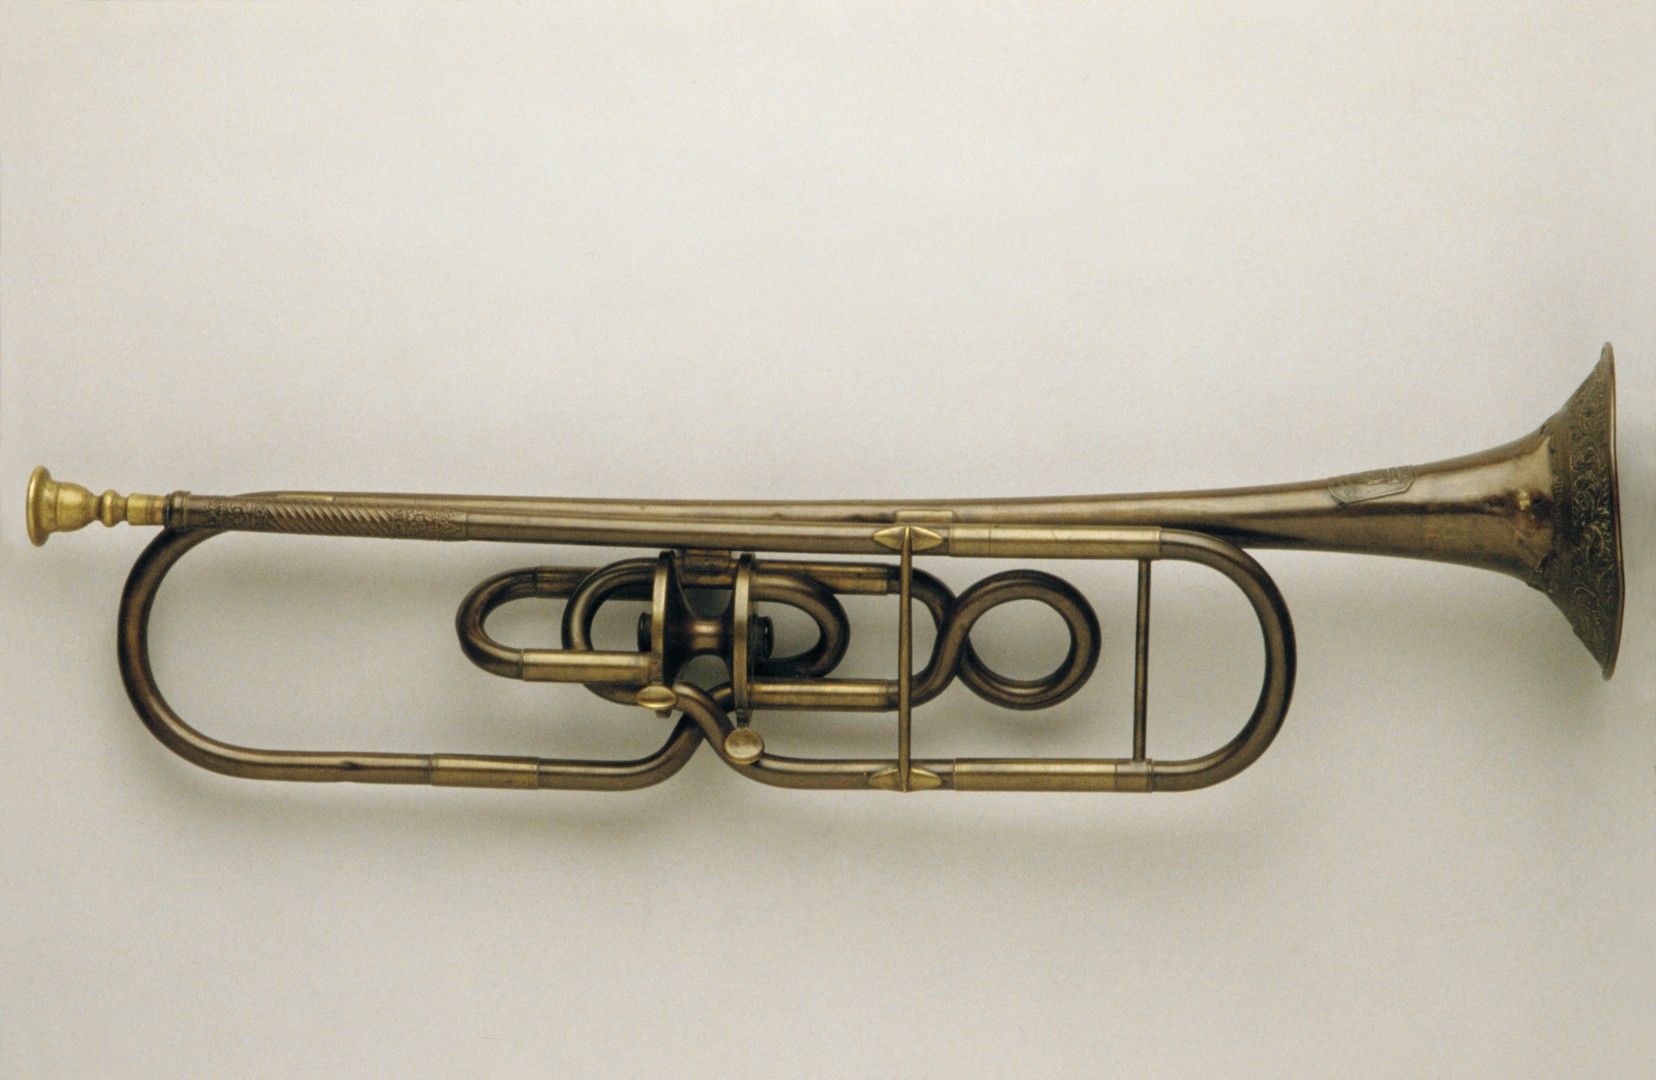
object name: valve trumpet in f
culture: british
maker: john augustus köhler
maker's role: maker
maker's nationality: british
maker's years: 1810-1878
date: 1839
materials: brass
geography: united kingdom